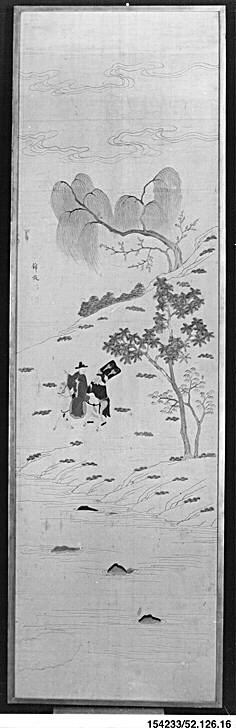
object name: screen panel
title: Screen Panel from Set of Six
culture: chinese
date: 1767-1833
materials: silk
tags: men,horses,trees